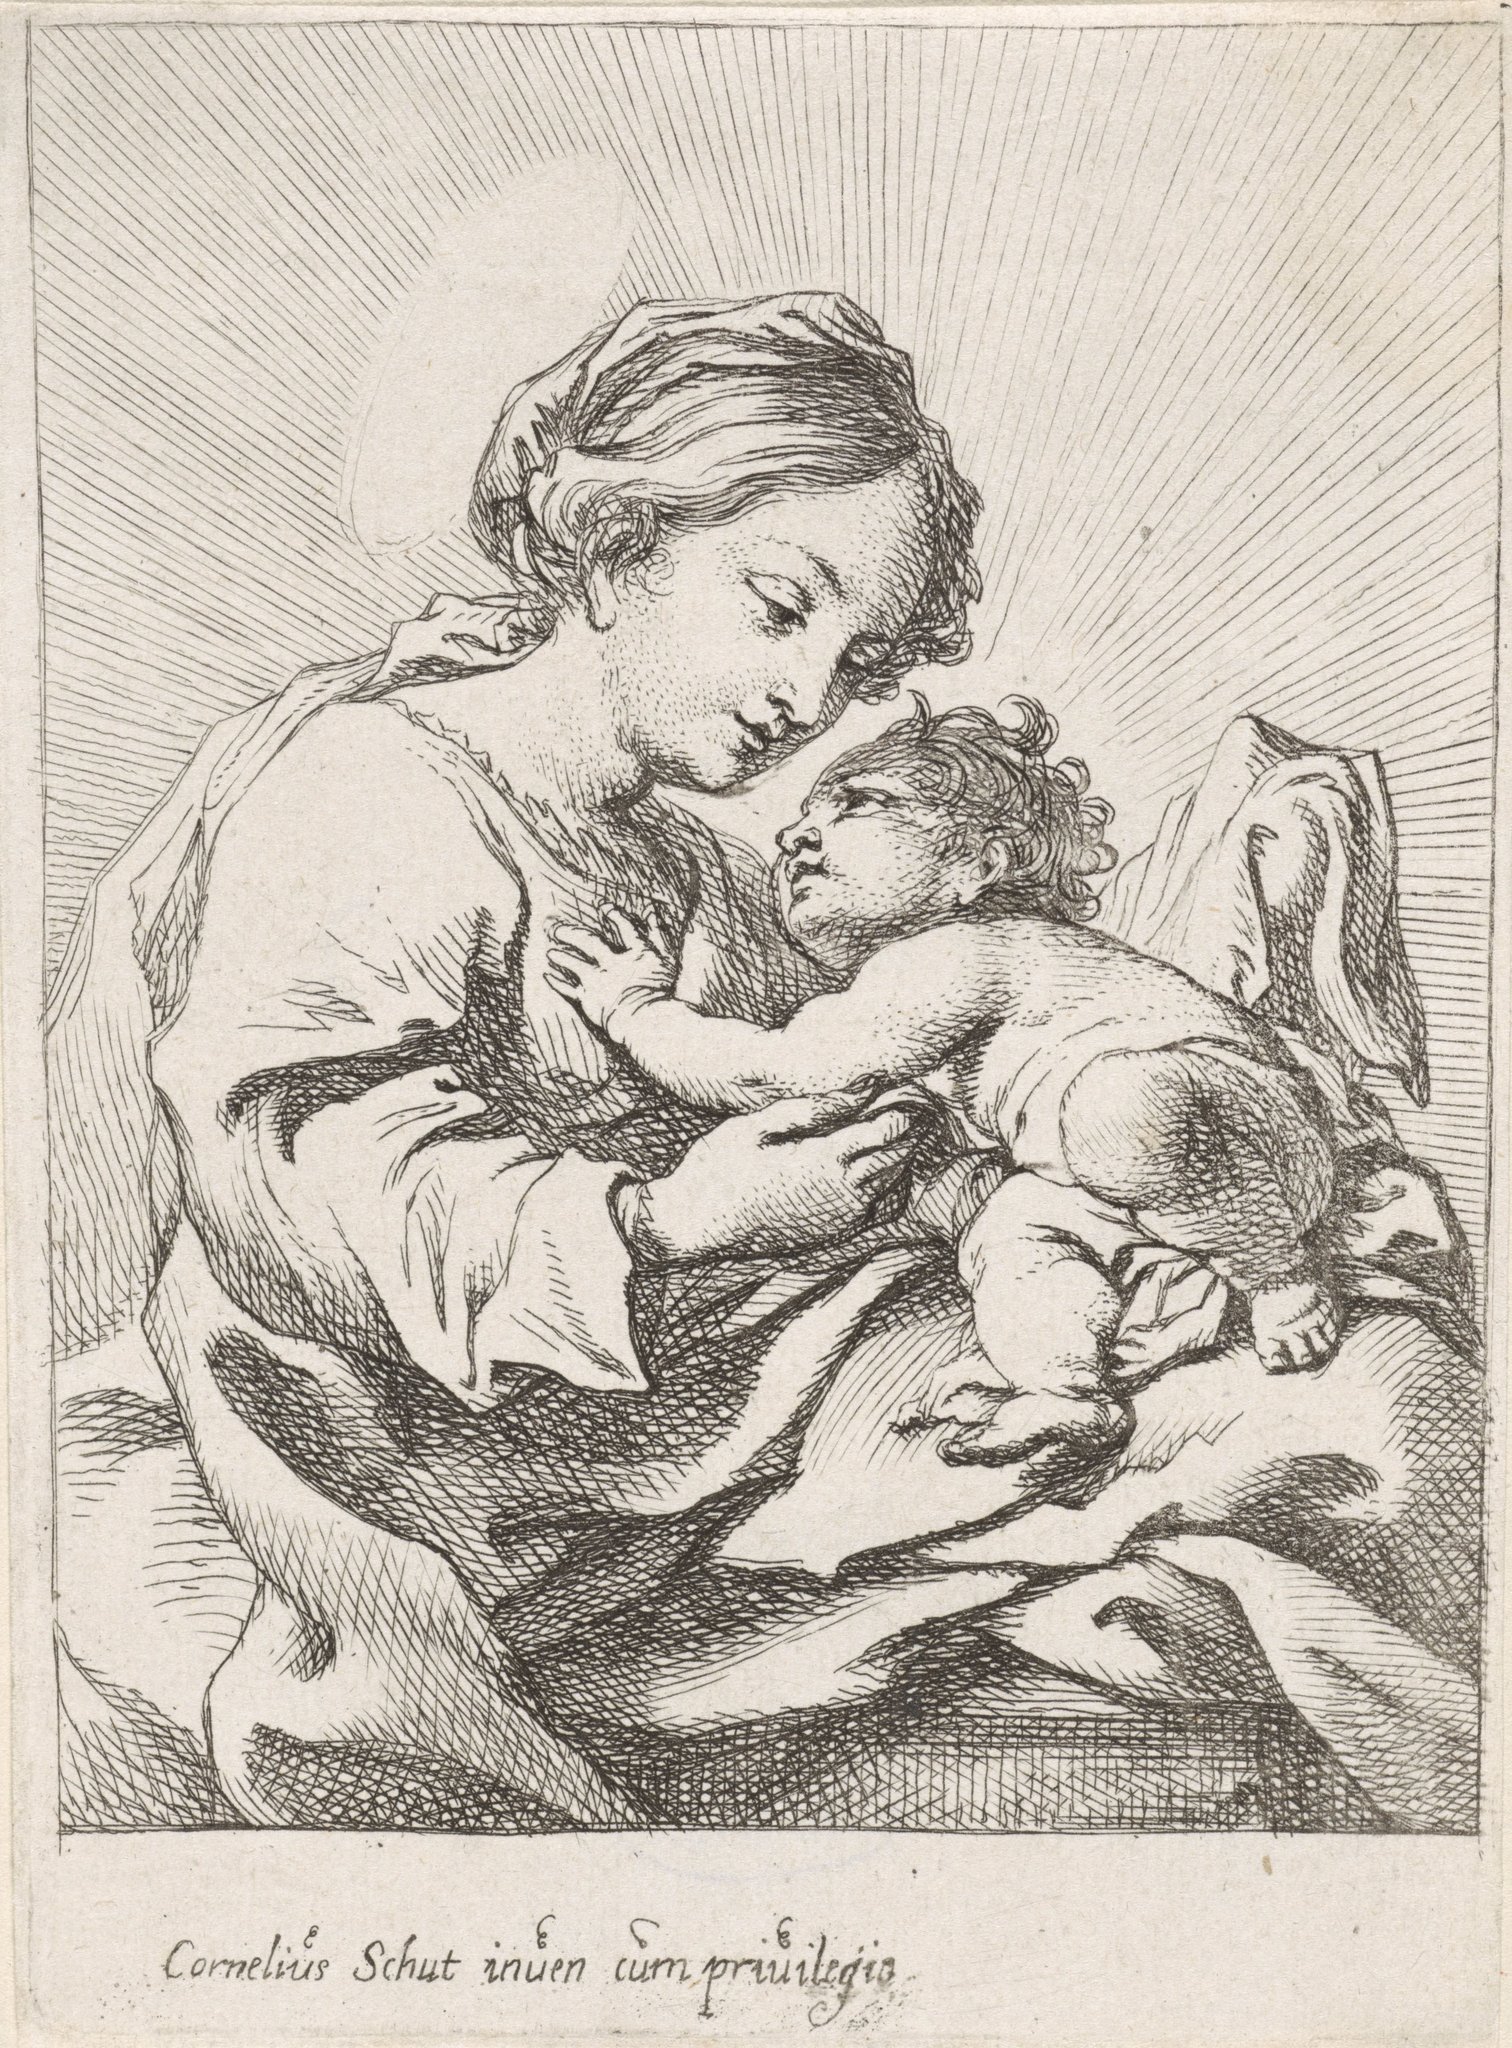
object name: print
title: Madonna met Kind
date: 1618-1655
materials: paper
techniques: etching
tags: madonna: mary sitting or enthroned, the christ-child in her lap (or in front of her bosom) (mary sometimes represented half-length)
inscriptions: collector's mark: Lugt 2228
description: Het Christuskind ligt op schoot bij Maria; hij keert zich naar haar toe.